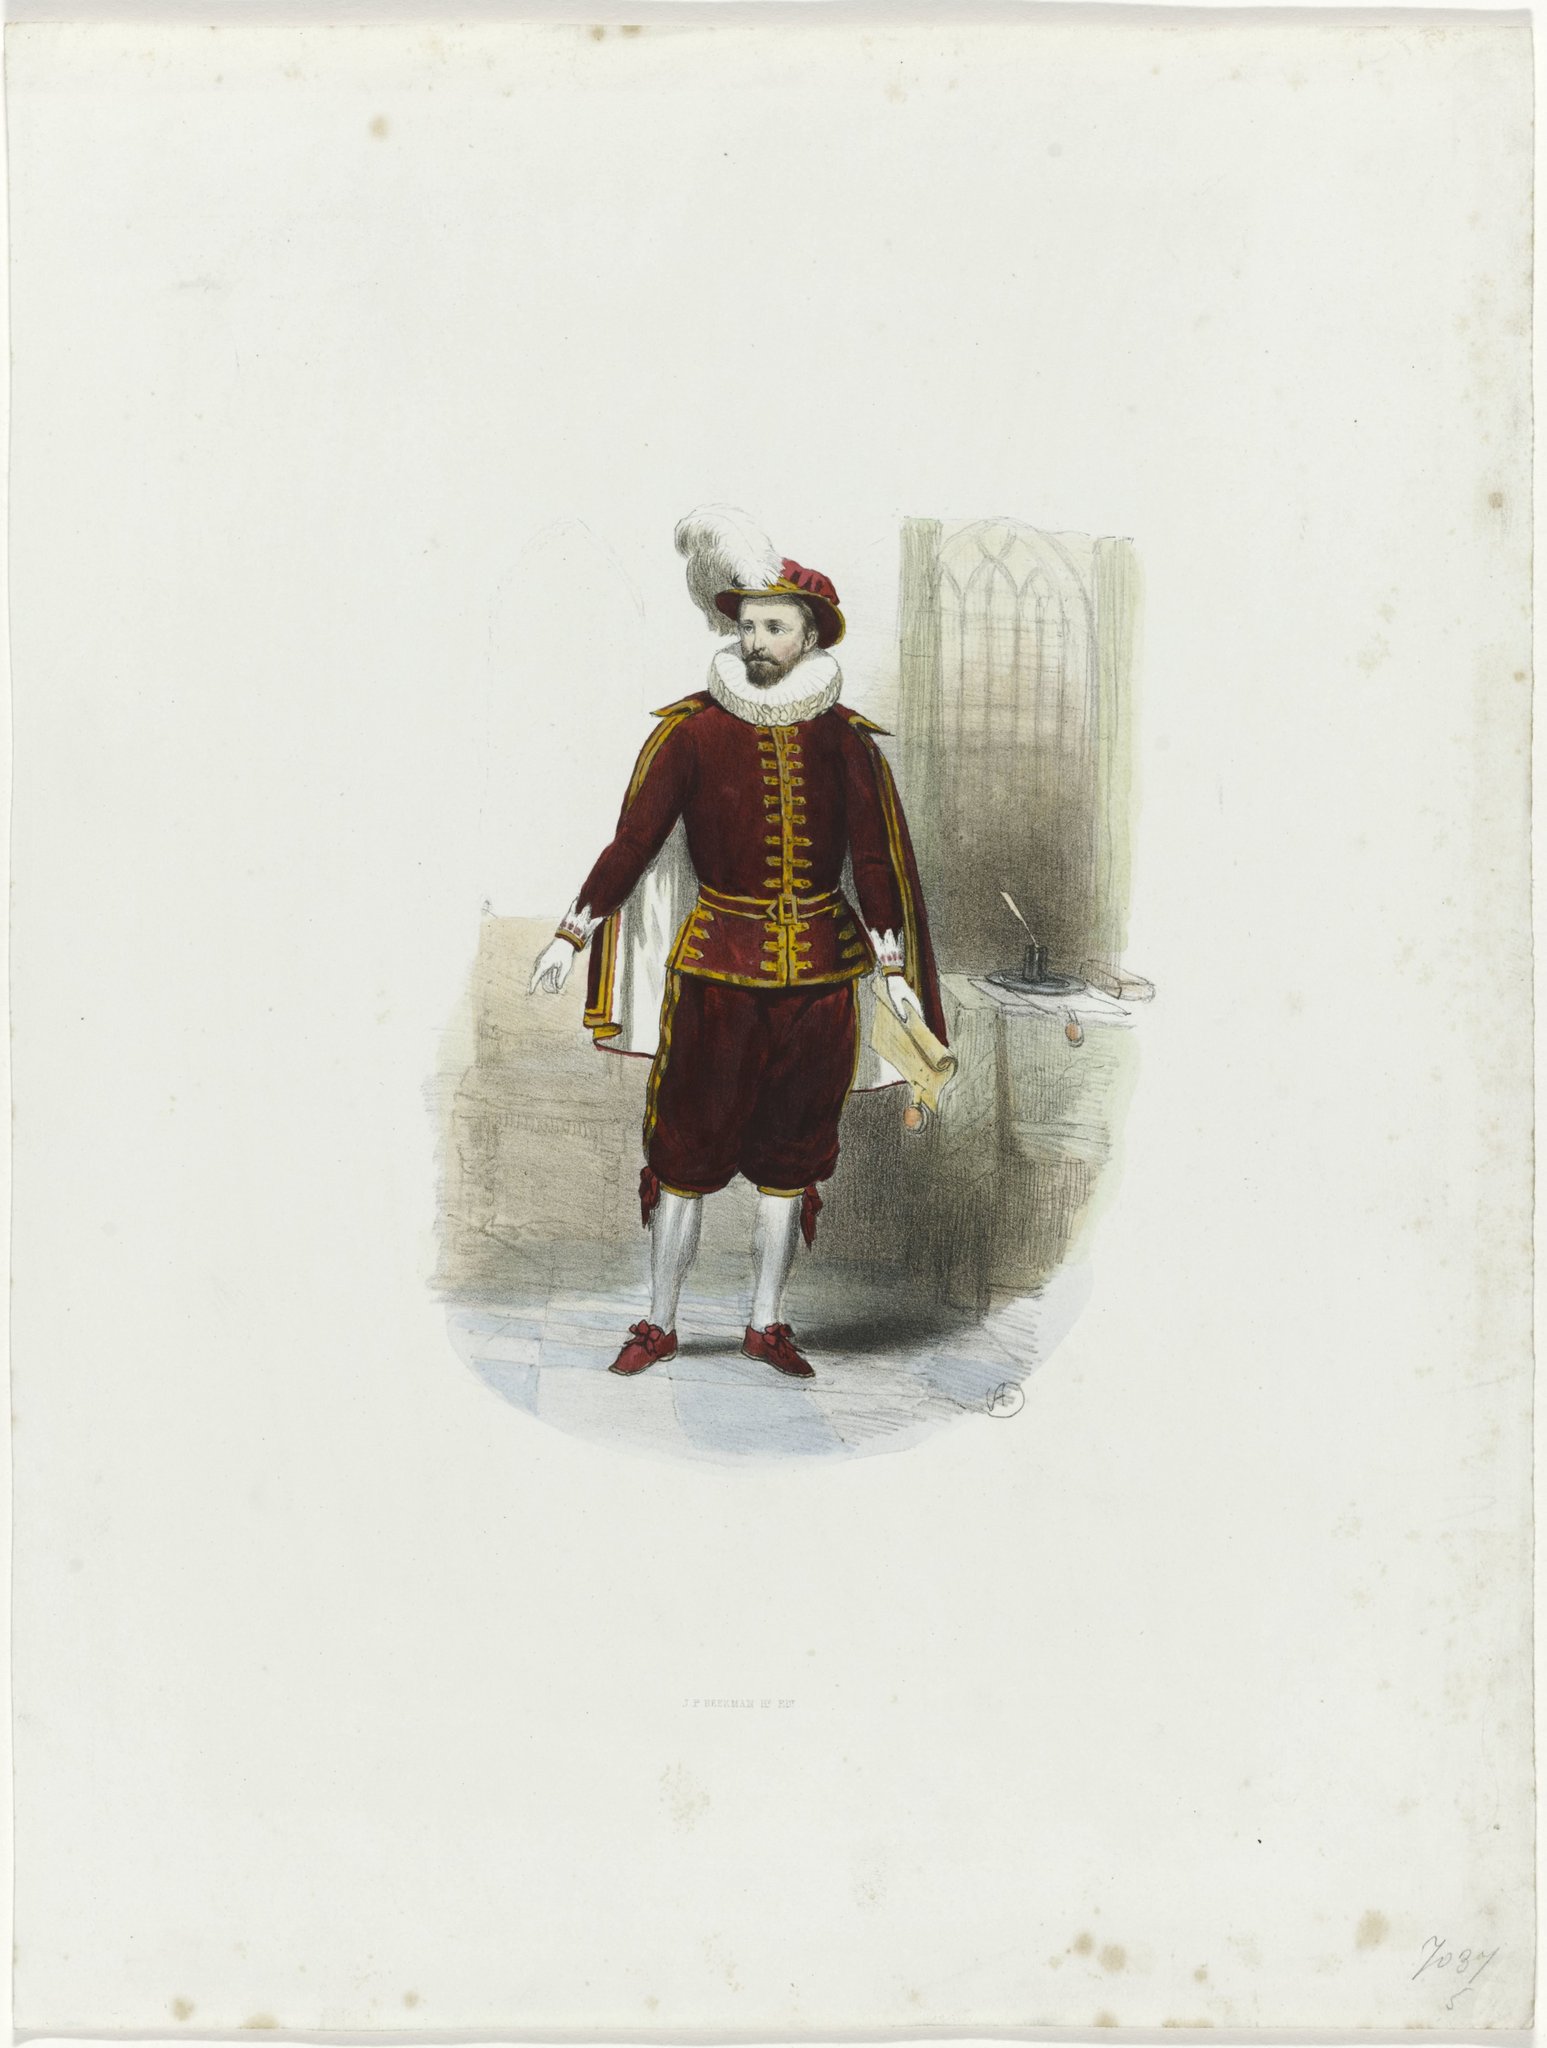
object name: print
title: Man in historisch kostuum, 1841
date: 1841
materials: paper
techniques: hand coloring, lithograph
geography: netherlands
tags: anna paulowna romanowa, the hague, william ii of the netherlands, historical costume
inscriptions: collector's mark: Lugt 2228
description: Man in historisch kostuum van een edelman. Onderdeel van het album bestaande uit een omslag en zes platen van kostuums gedragen op het gekostumeerde bal gehouden te Den Haag op 17 en 19 februari 1841 ter gelegenheid van het 25-jarig huwelijk van koning Willem II en Anna Paulowna.